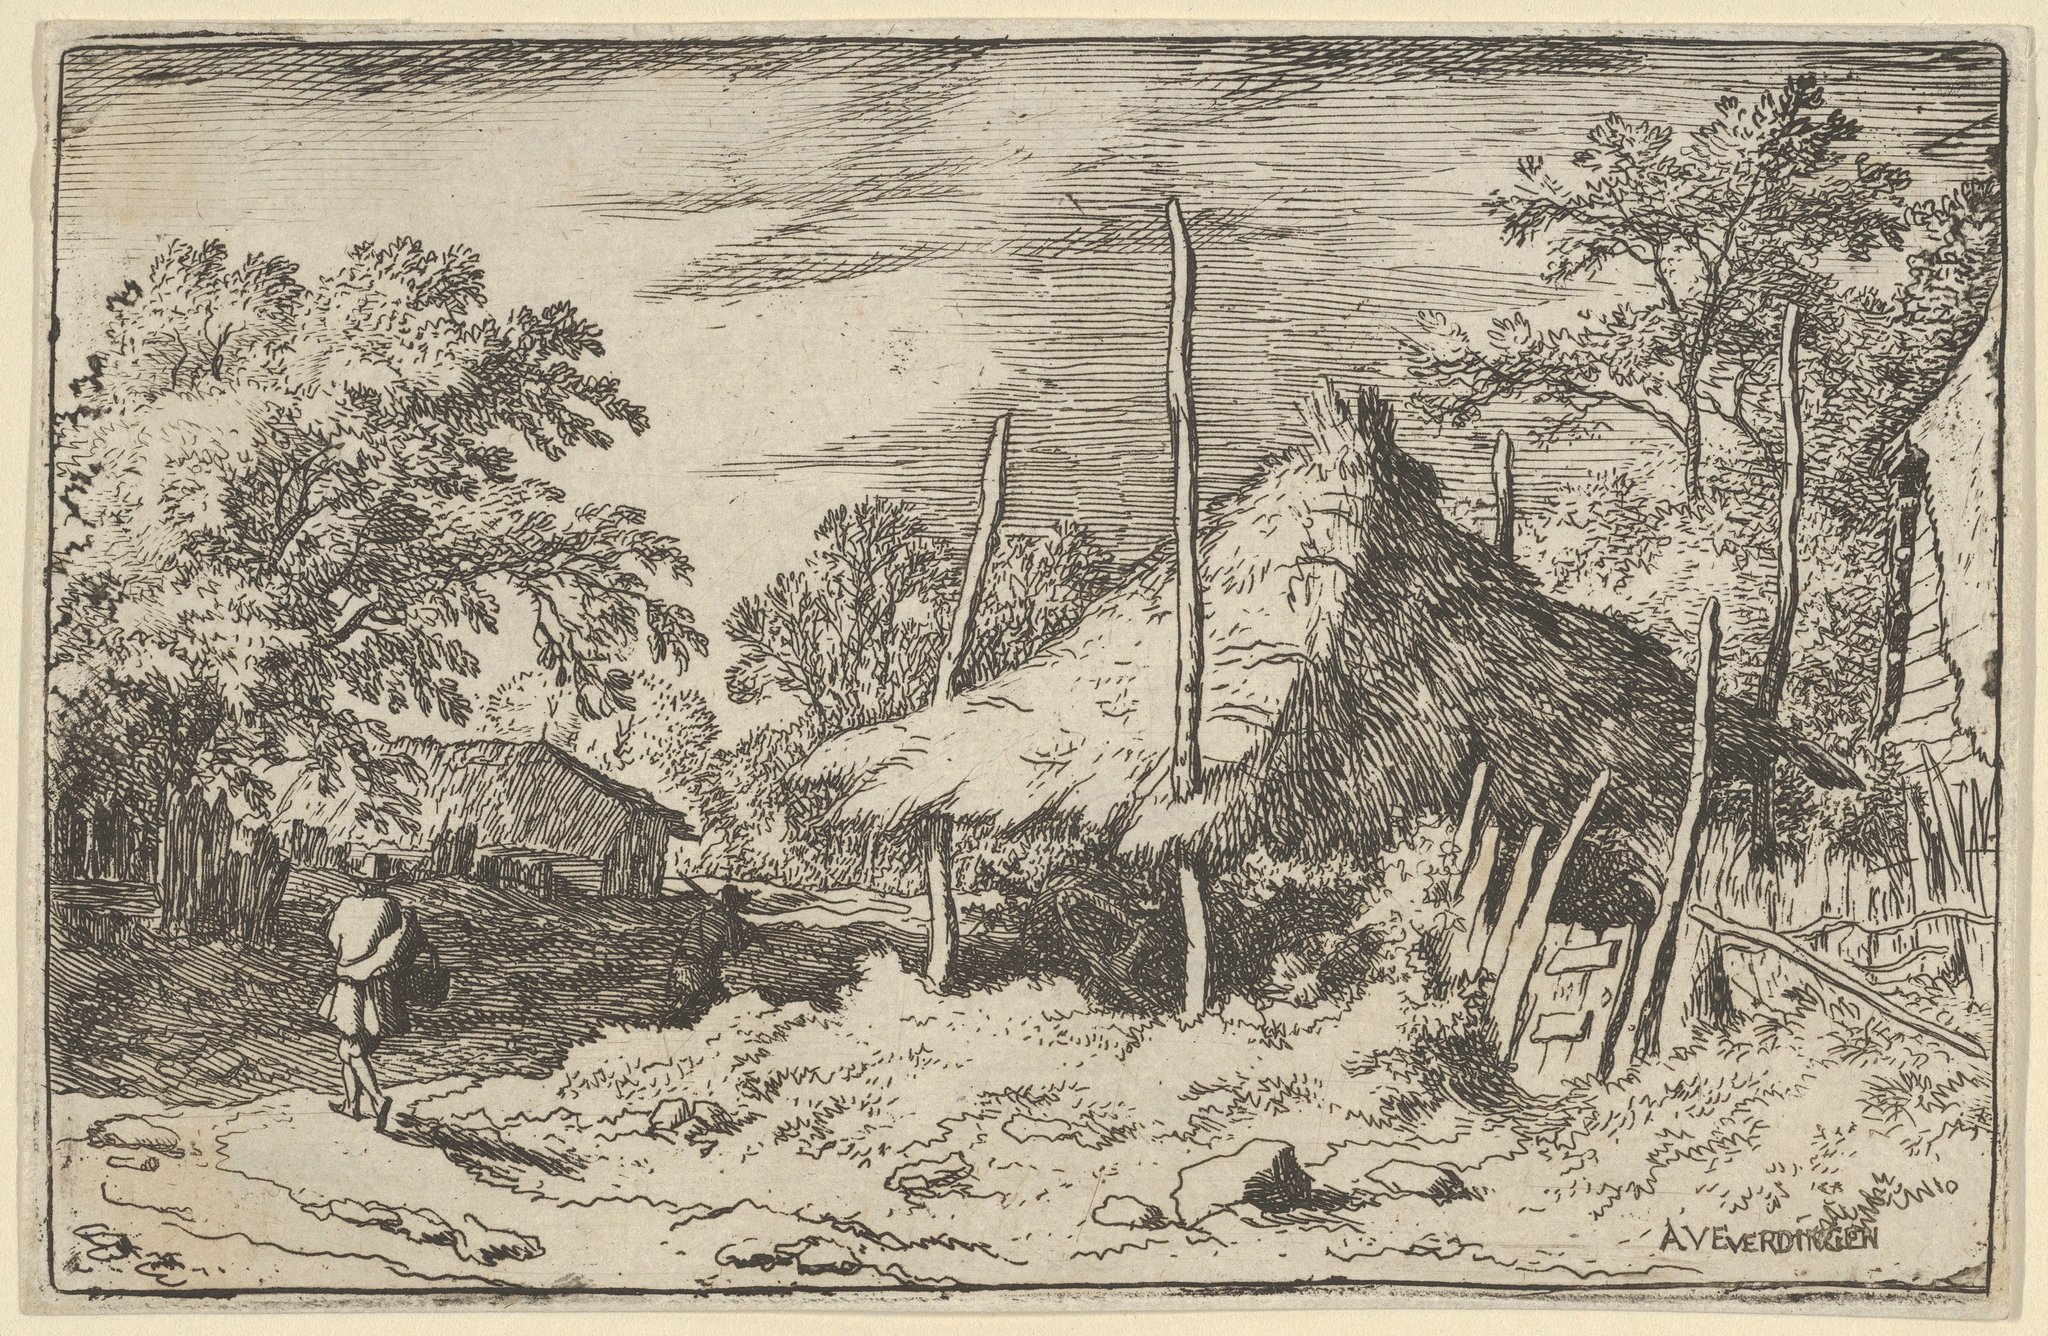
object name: print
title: The Wheel underneath the Haybarn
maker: allart van everdingen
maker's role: artist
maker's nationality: dutch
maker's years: 1621-1675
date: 1621-1675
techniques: engraving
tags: barns,landscapes